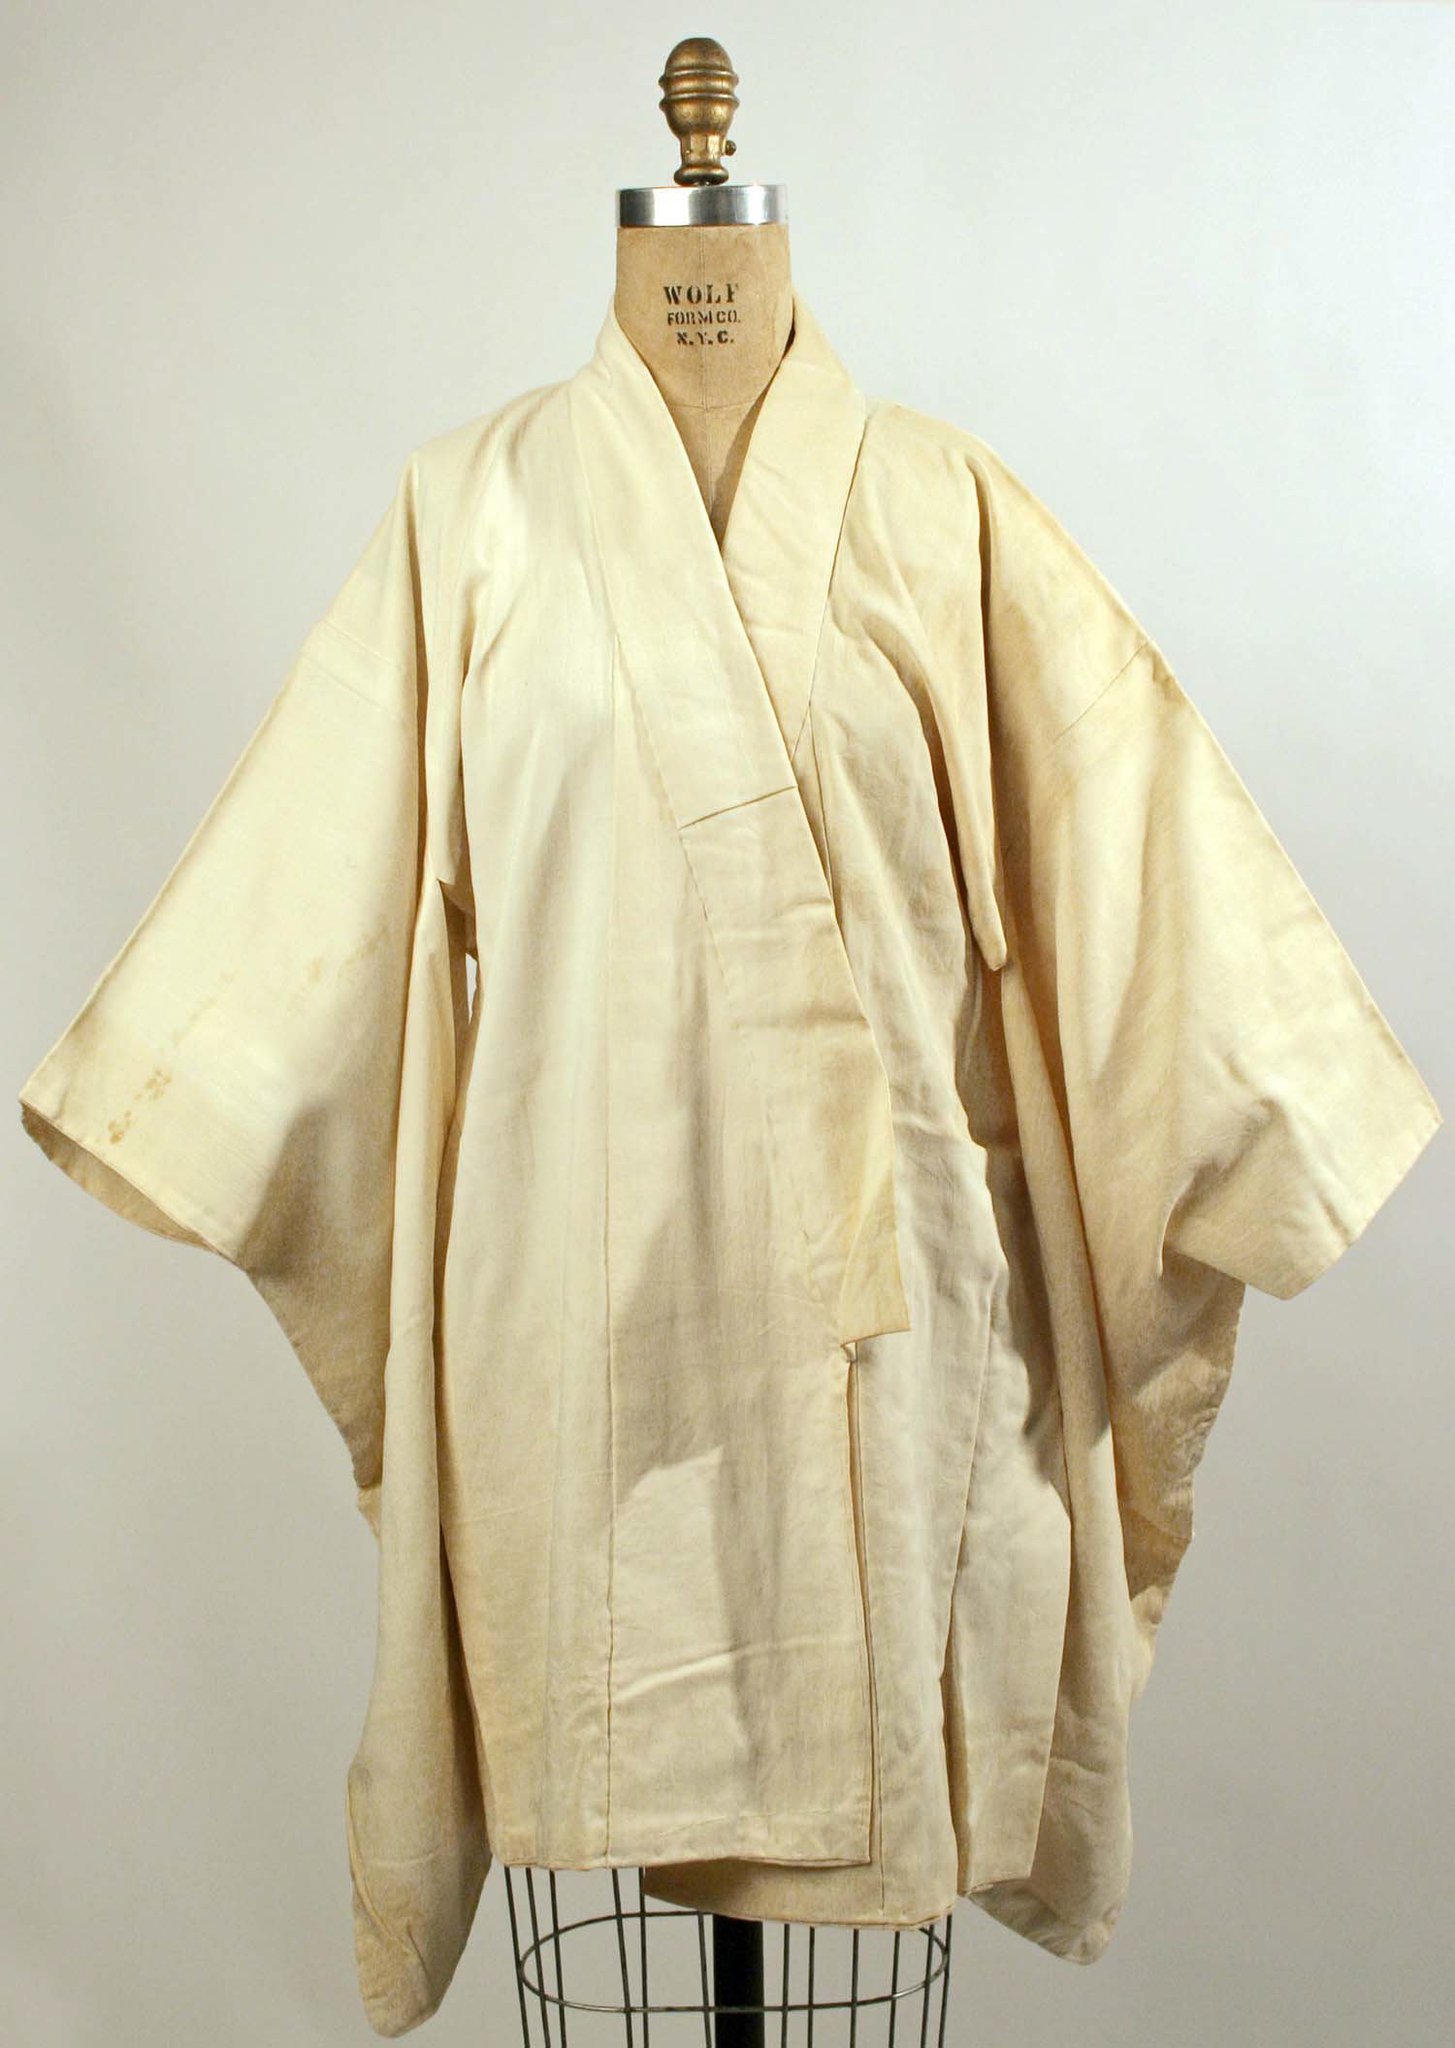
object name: dance ensemble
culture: japanese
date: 1901-2000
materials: silk